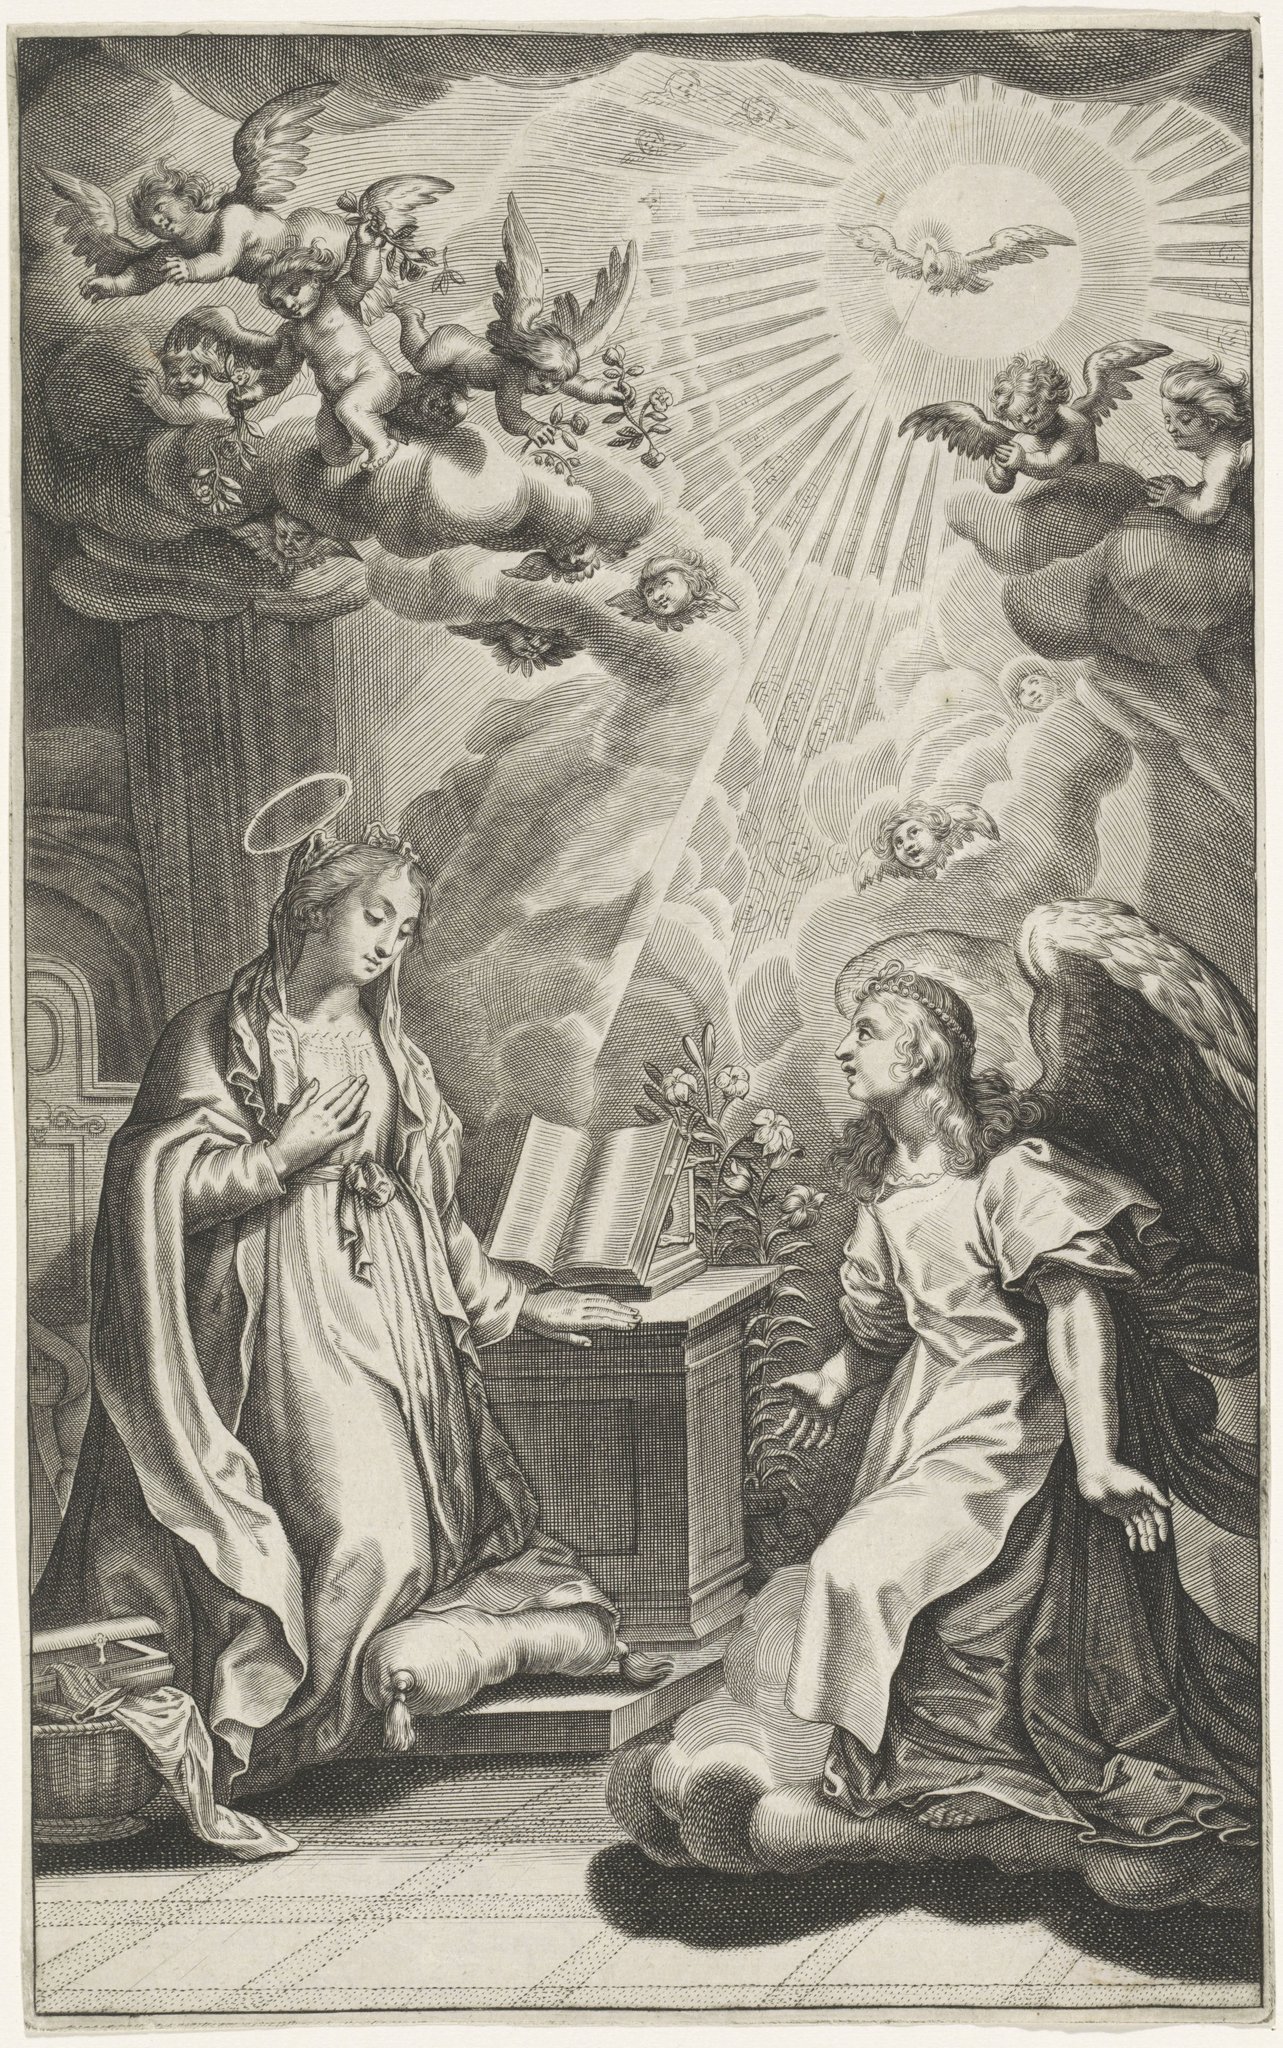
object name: print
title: Annunciatie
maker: Anonymous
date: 1629-1729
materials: paper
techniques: engraving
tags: the annunciation: mary, usually reading, is visited by the angel (sometimes a woman overhears the conversation)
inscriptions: collector's mark: Lugt 240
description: De engel Gabriël kondigt aan Maria aan dat ze zwanger zal worden. Maria zit geknield op een kussen bij een lessenaar, waarop een opengeslagen boek ligt. In de rechterbovenhoek daalt de Heilige Geest als een duif neer. In de lucht putti en cherubijnen.